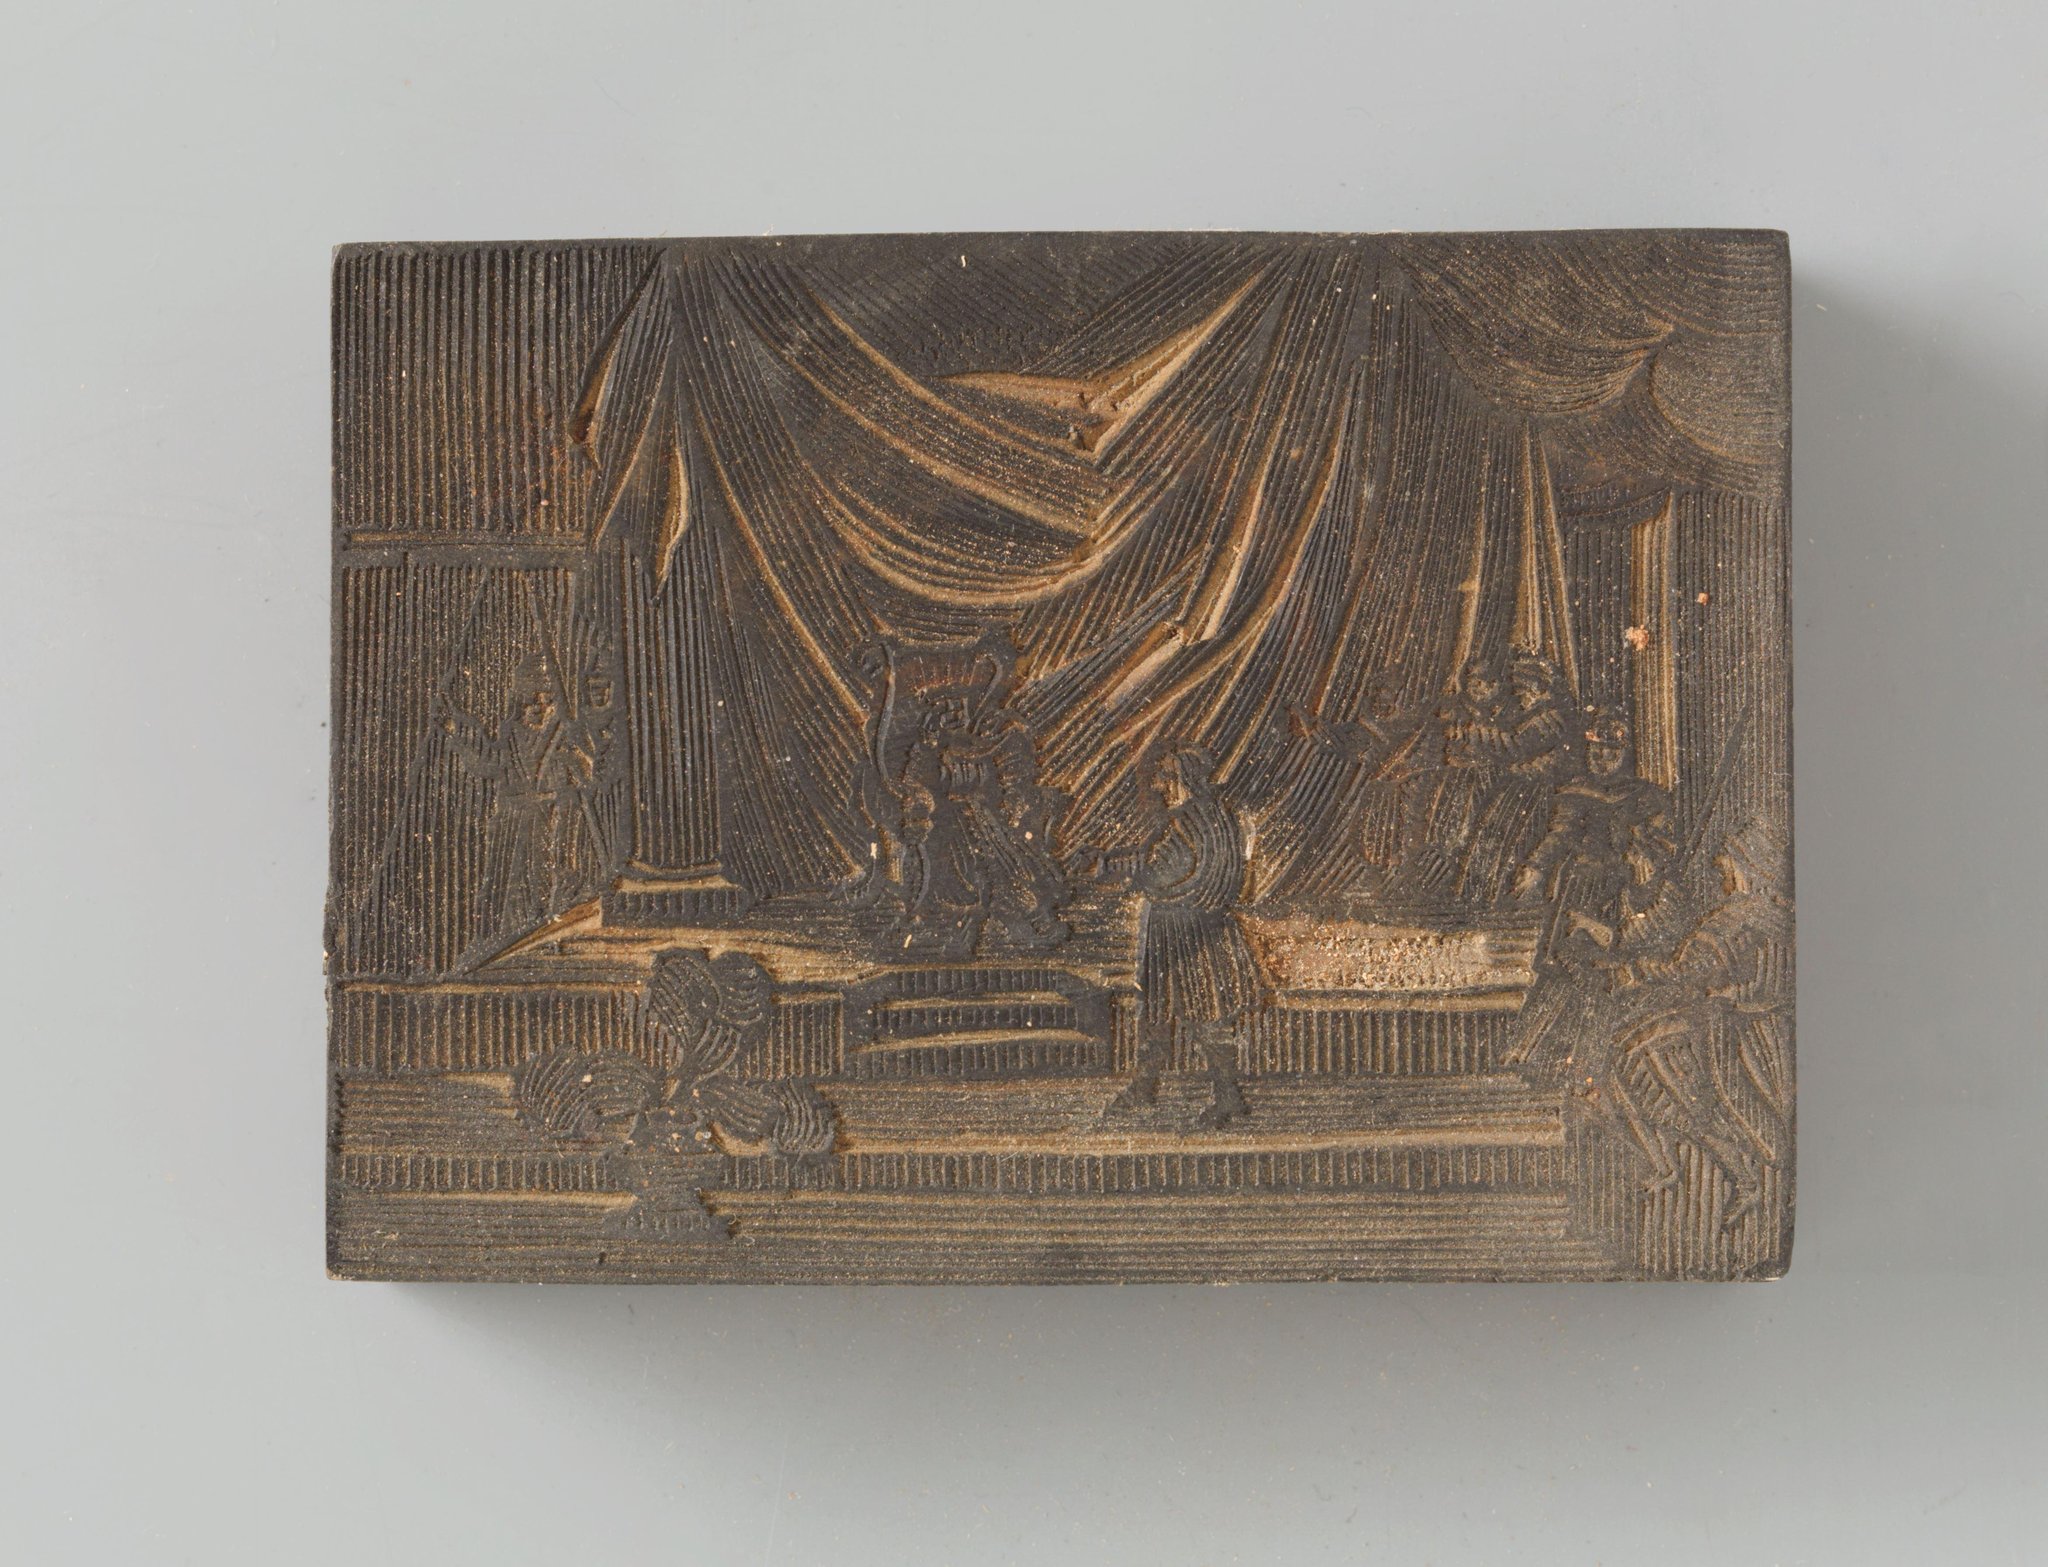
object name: wood block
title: Bijbel-illustraties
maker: Anonymous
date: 1550-1699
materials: wood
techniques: woodcut